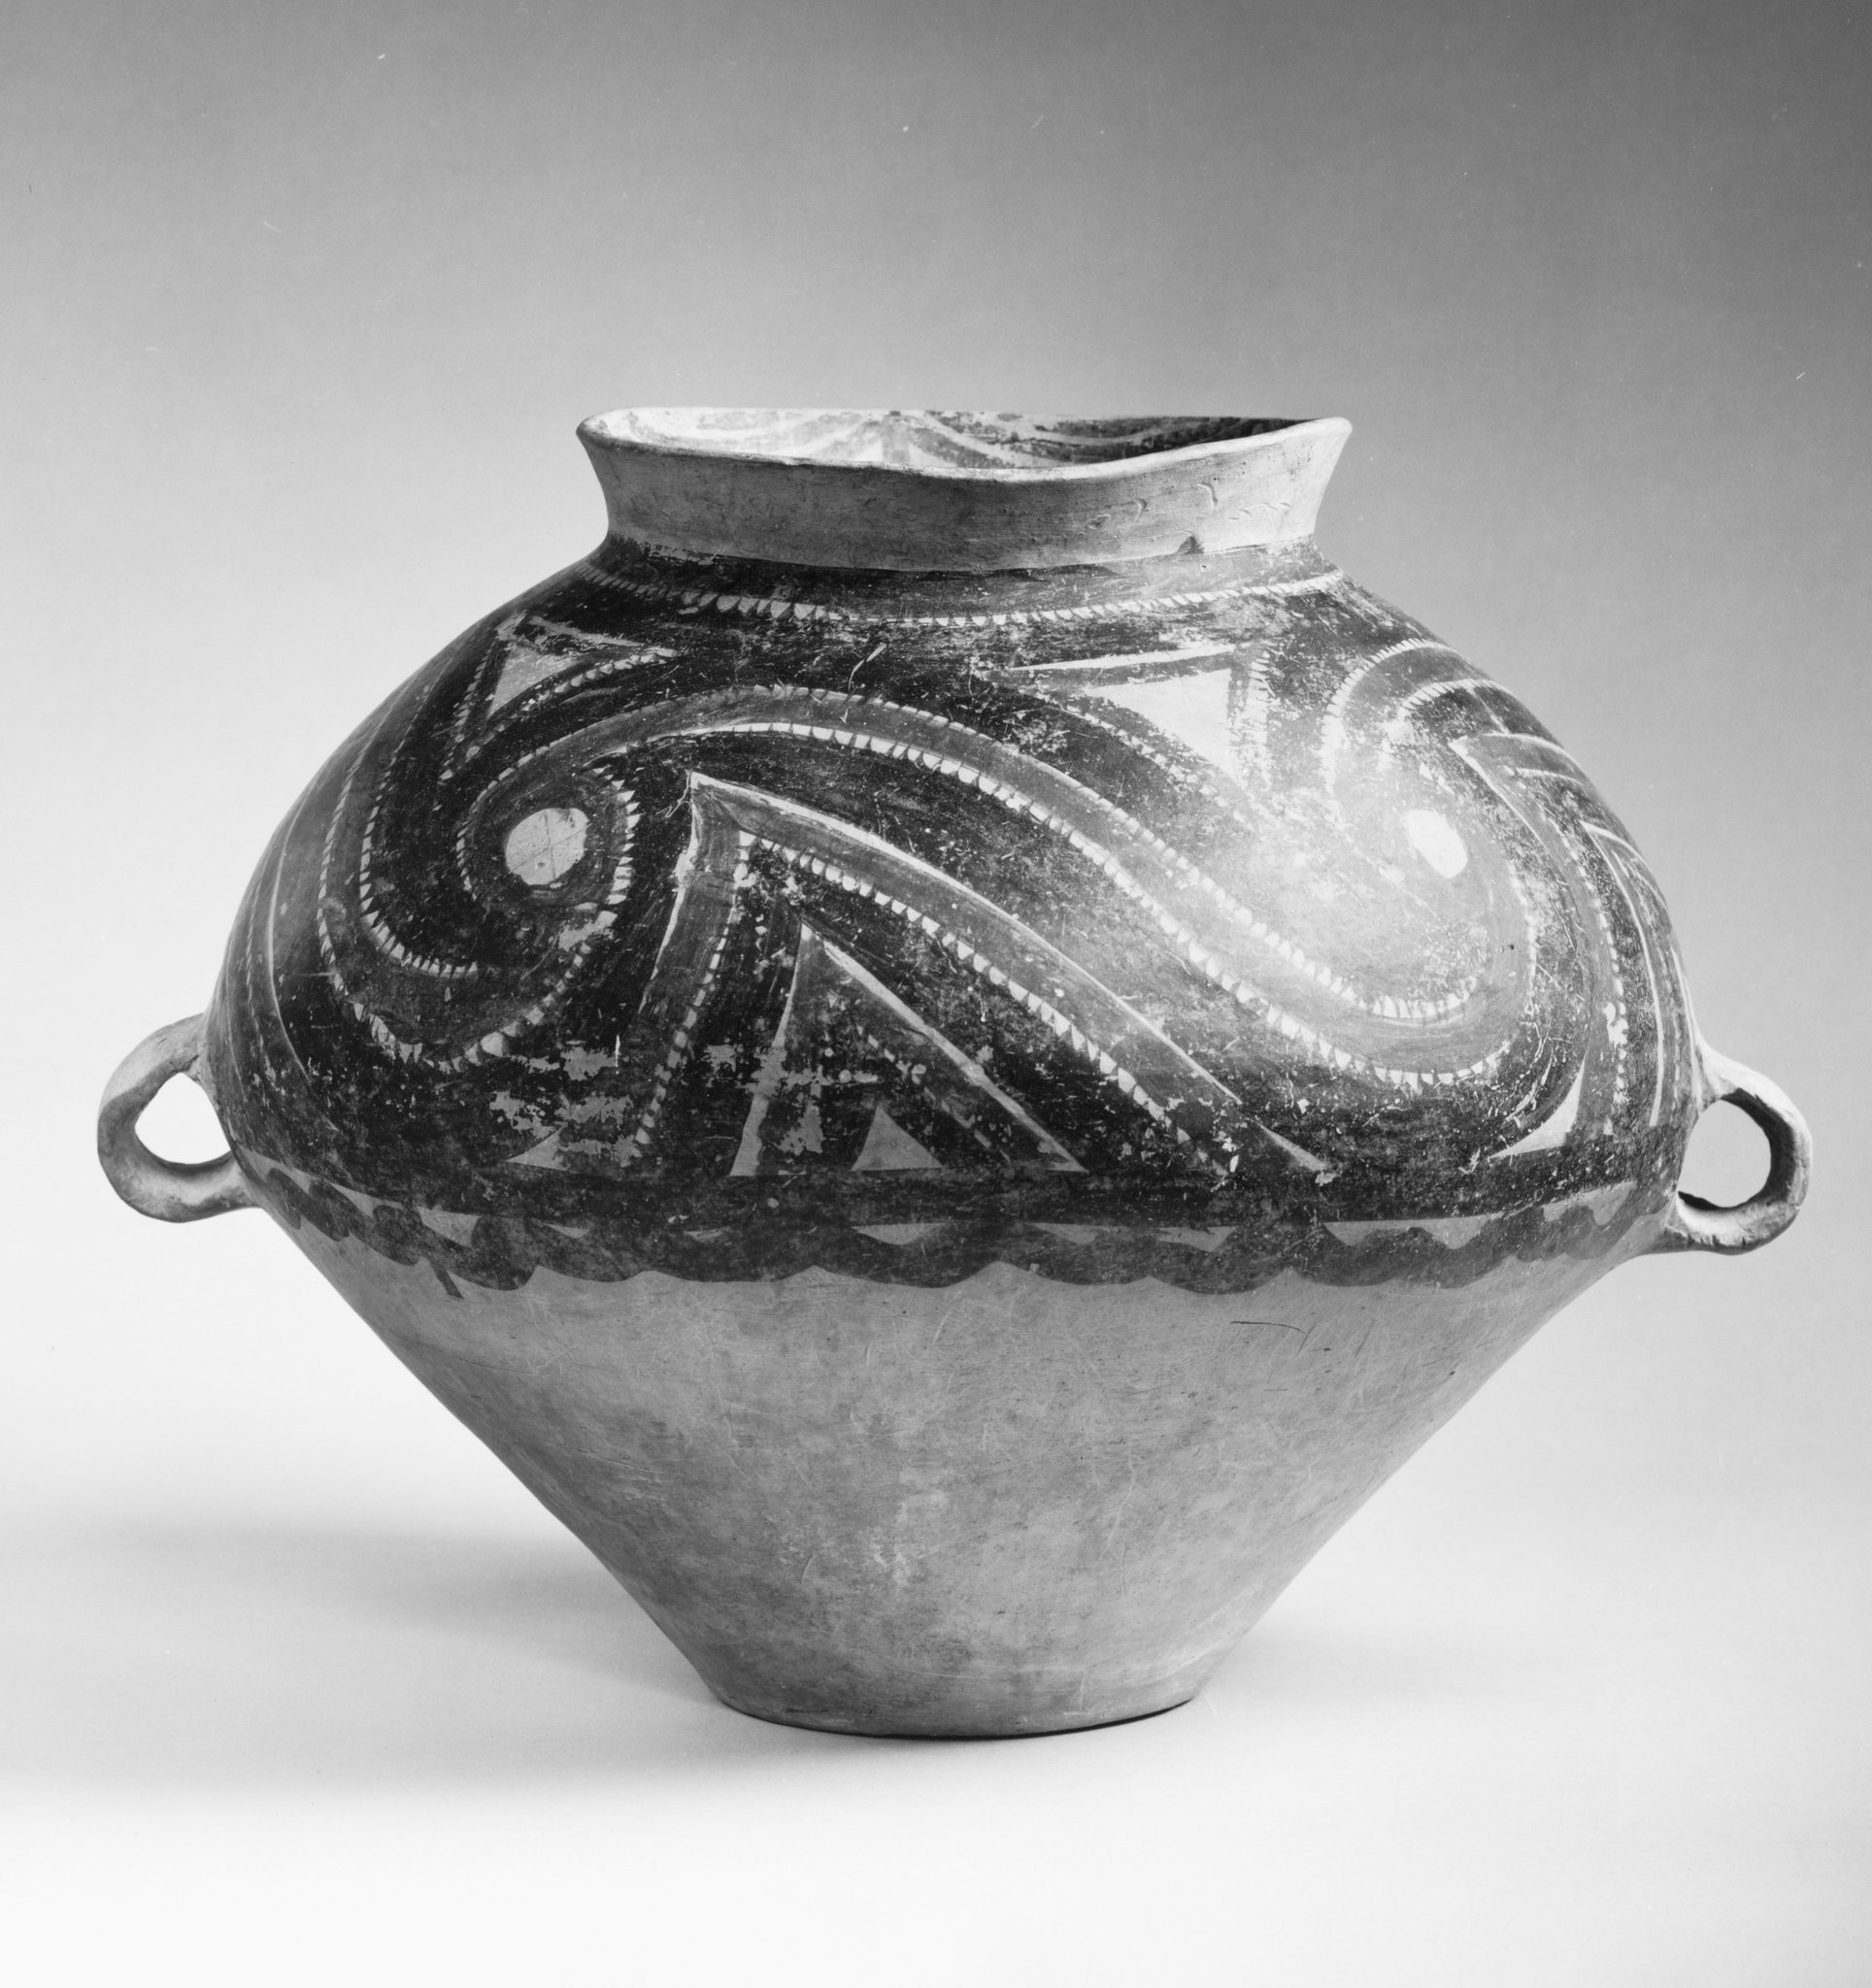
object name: jar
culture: chinese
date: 2600-2300 BCE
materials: earthenware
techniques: painting